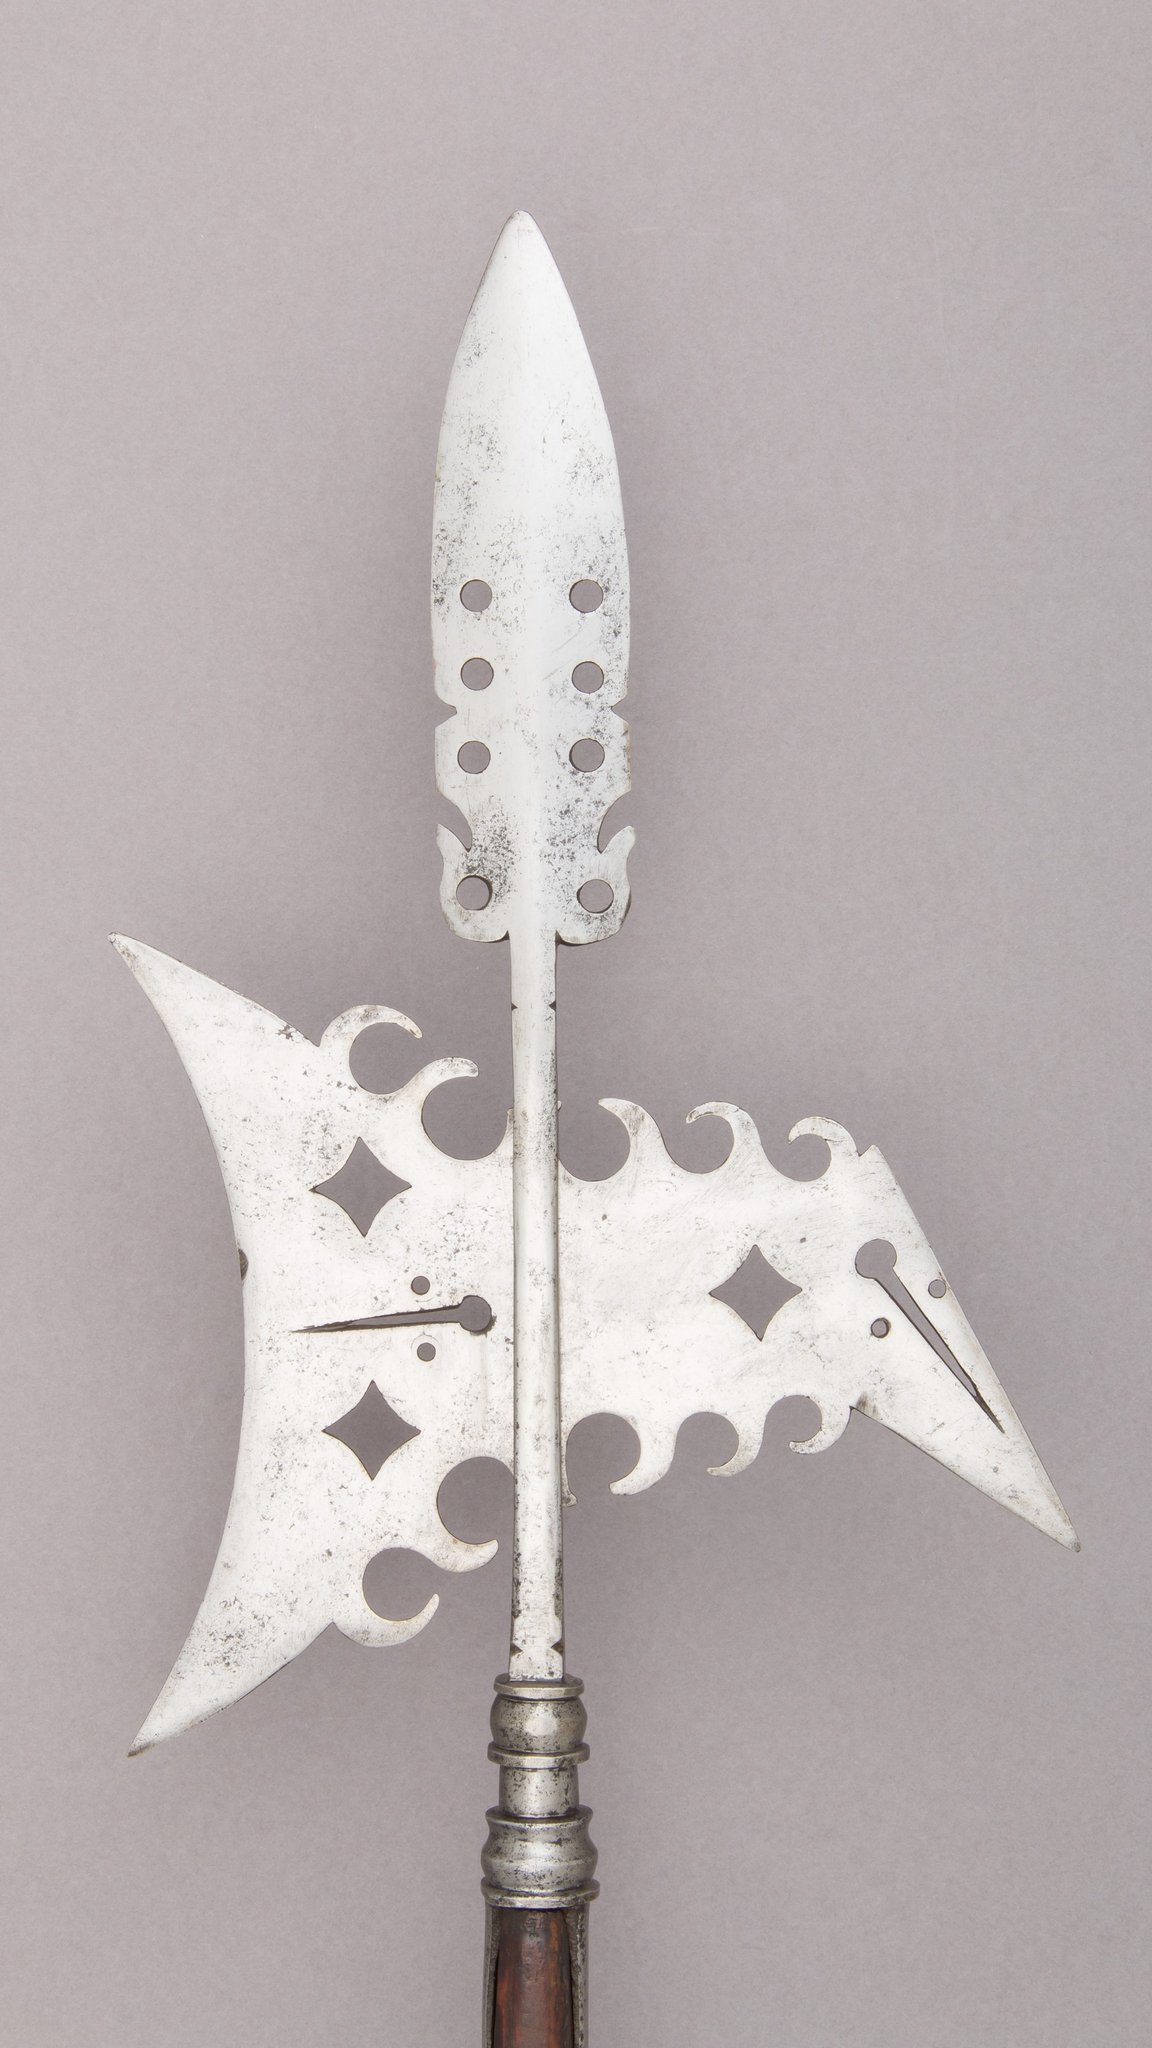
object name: halberd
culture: american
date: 1750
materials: steel, wood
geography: united states